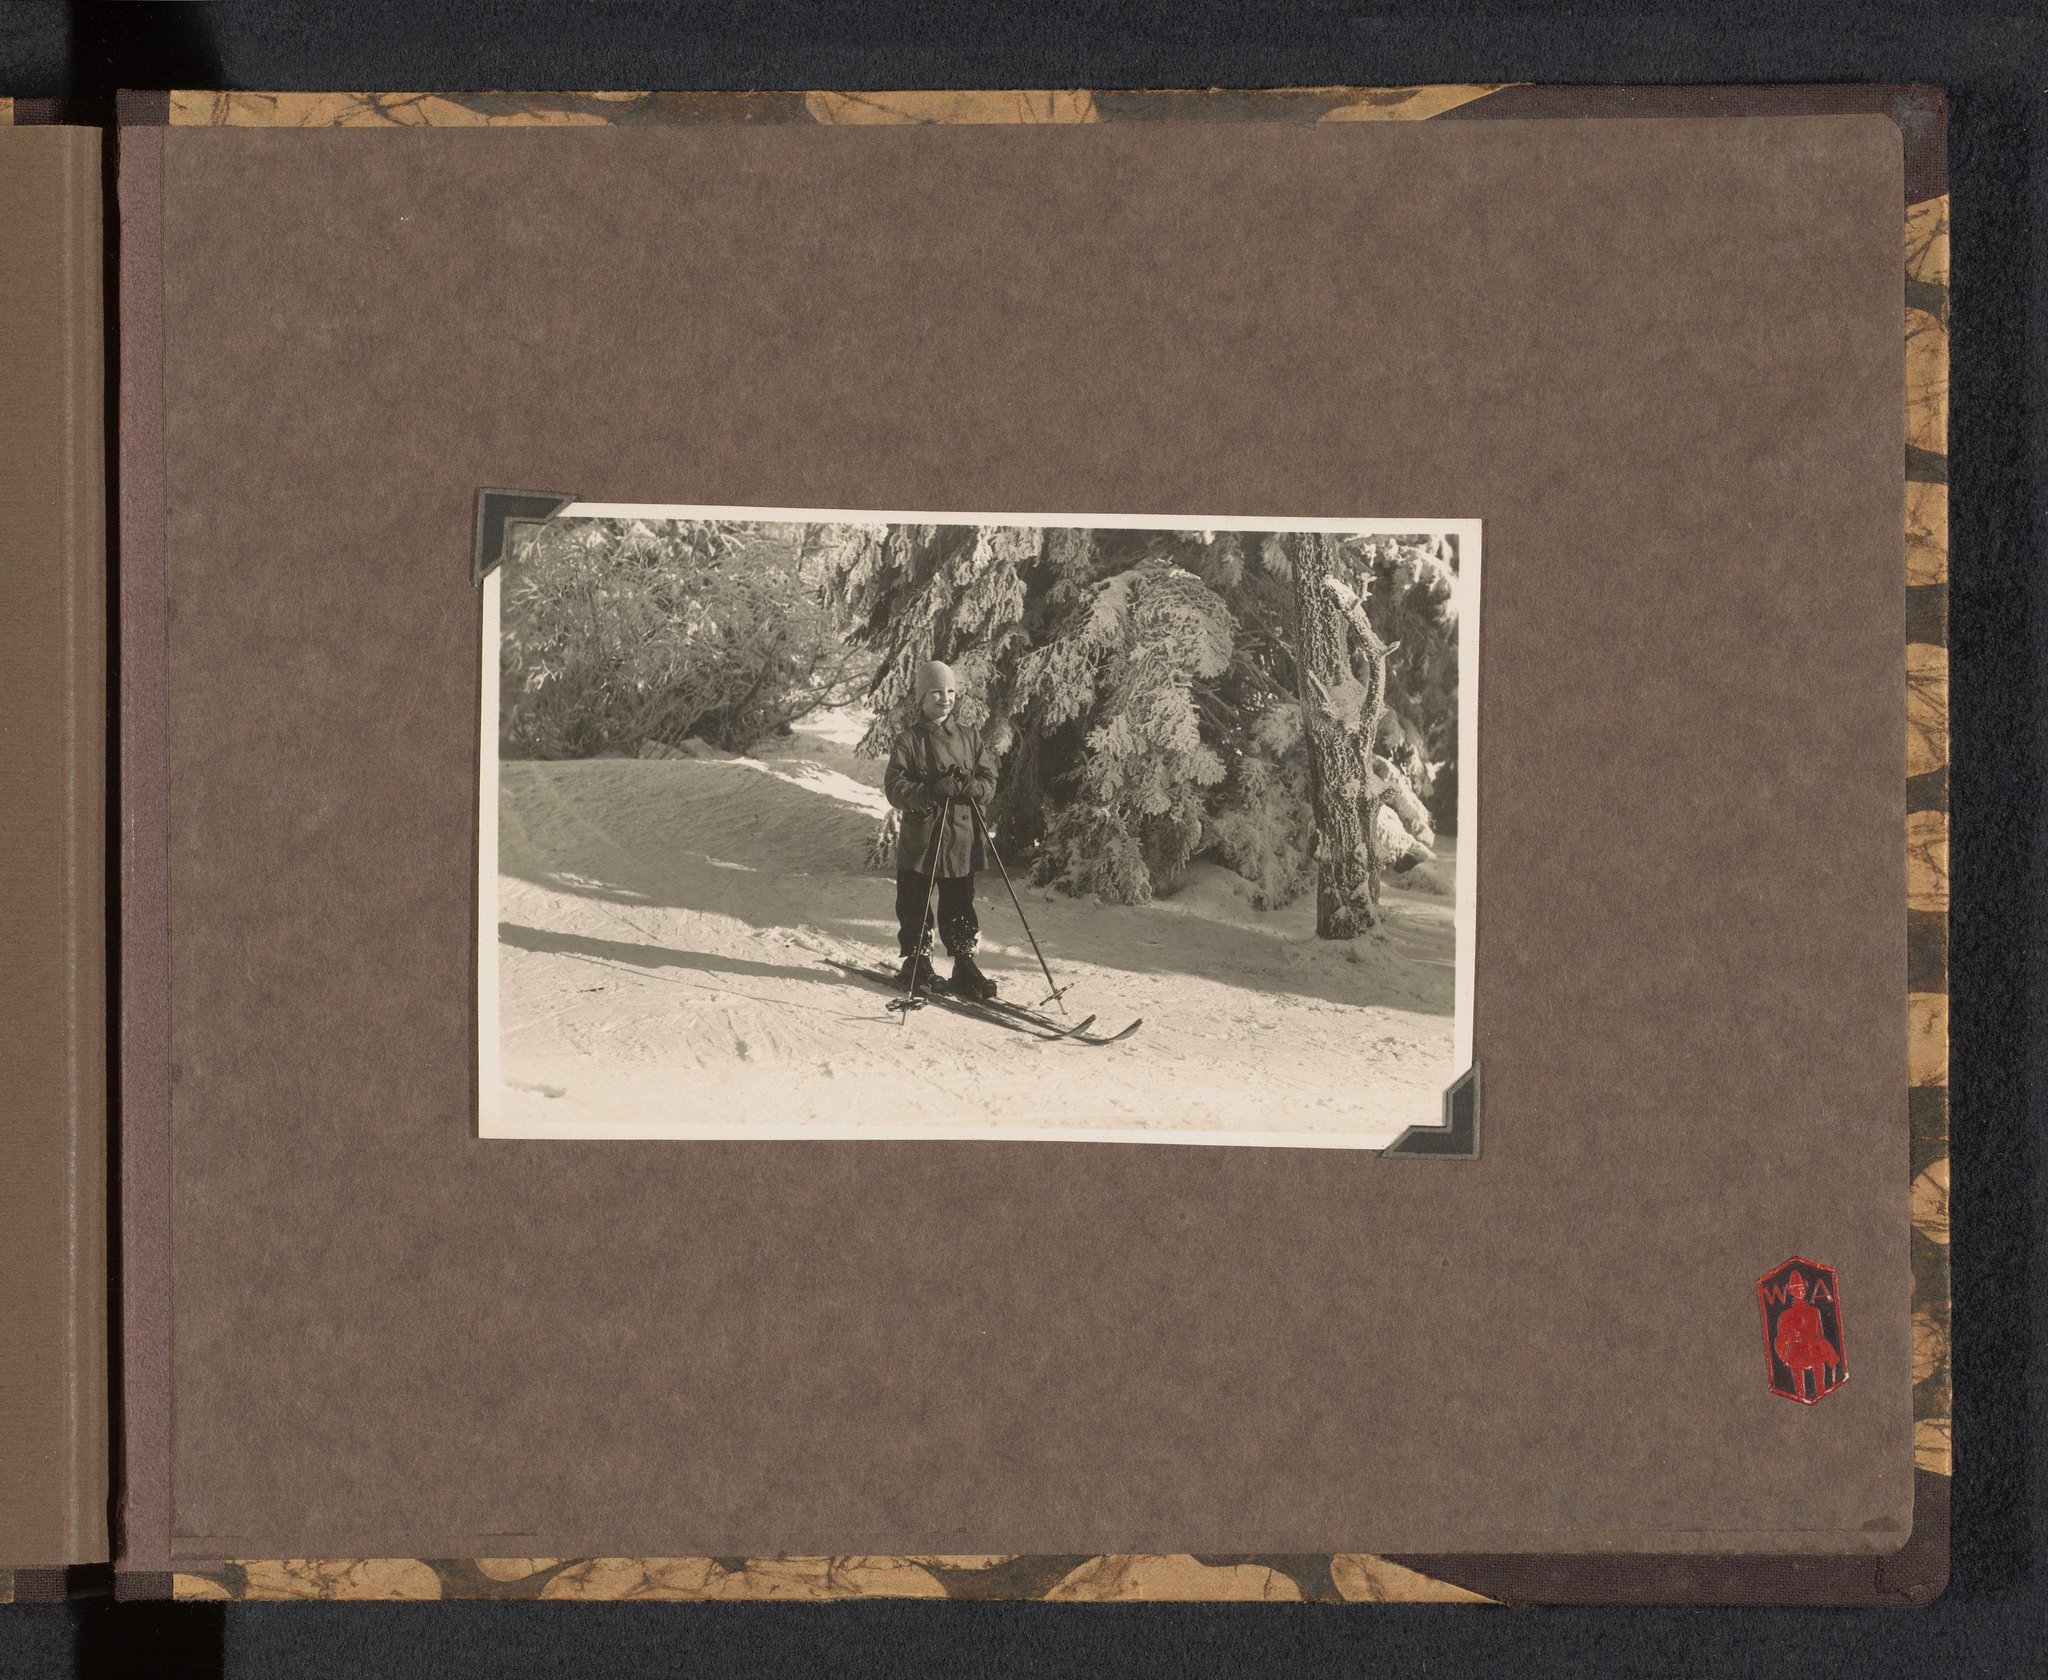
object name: album leaf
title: Onbekende personen, mogelijk tijdens rondreis van Eugen Wachenheimer en Else Wachenheimer-Moos door Bulgarije, 1926-1927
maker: else wachenheimer-moos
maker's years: 1895-1944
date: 1926-1927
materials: paper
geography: bulgaria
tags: bulgarije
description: Albumblad bevat een foto's van onbekende personen. Afkomstig uit album half formaat, kartonomslag met koordbinding en lichte veelvormige vormen op voorzijde.